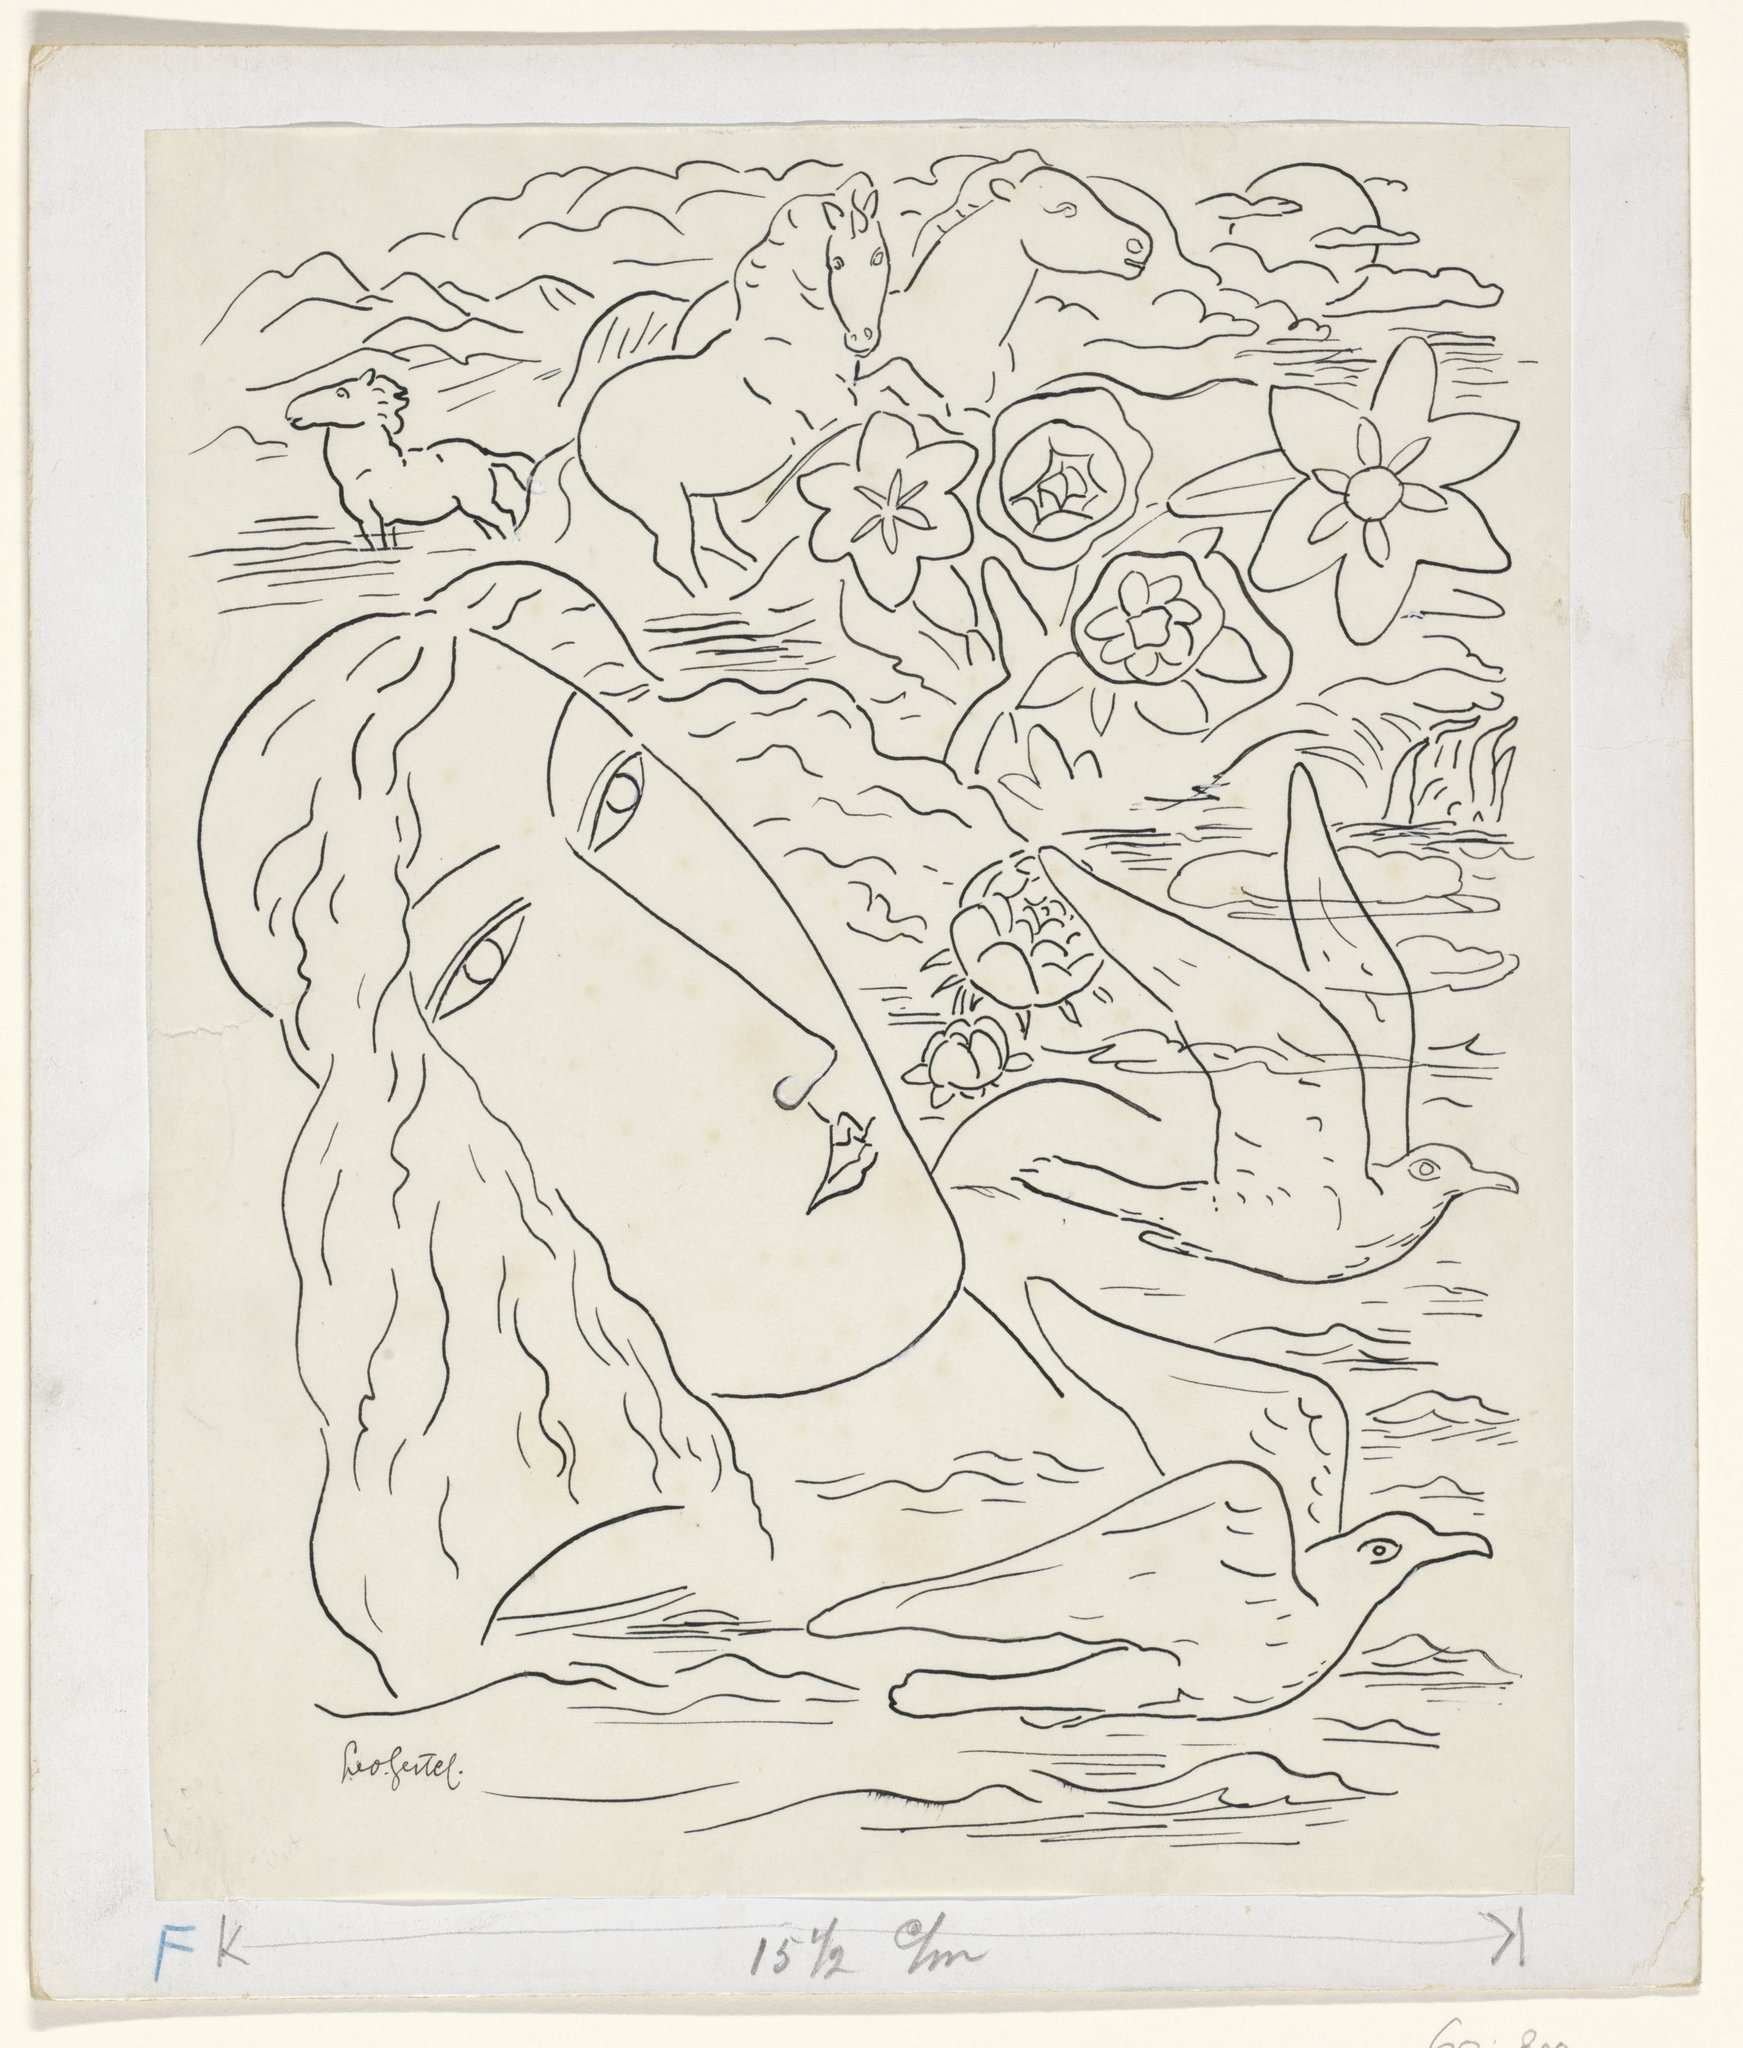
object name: design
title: Vrouwenhoofd met meeuwen, paarden en bloemen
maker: leo gestel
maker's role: draughtsman, print maker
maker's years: 1881-1941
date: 1891-1941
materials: paint, ink, paper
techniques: pen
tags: flowers, shore-birds and wading-birds: gull, horse, head (human) - aa - female human figure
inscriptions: :, collector's mark: Lugt 2228